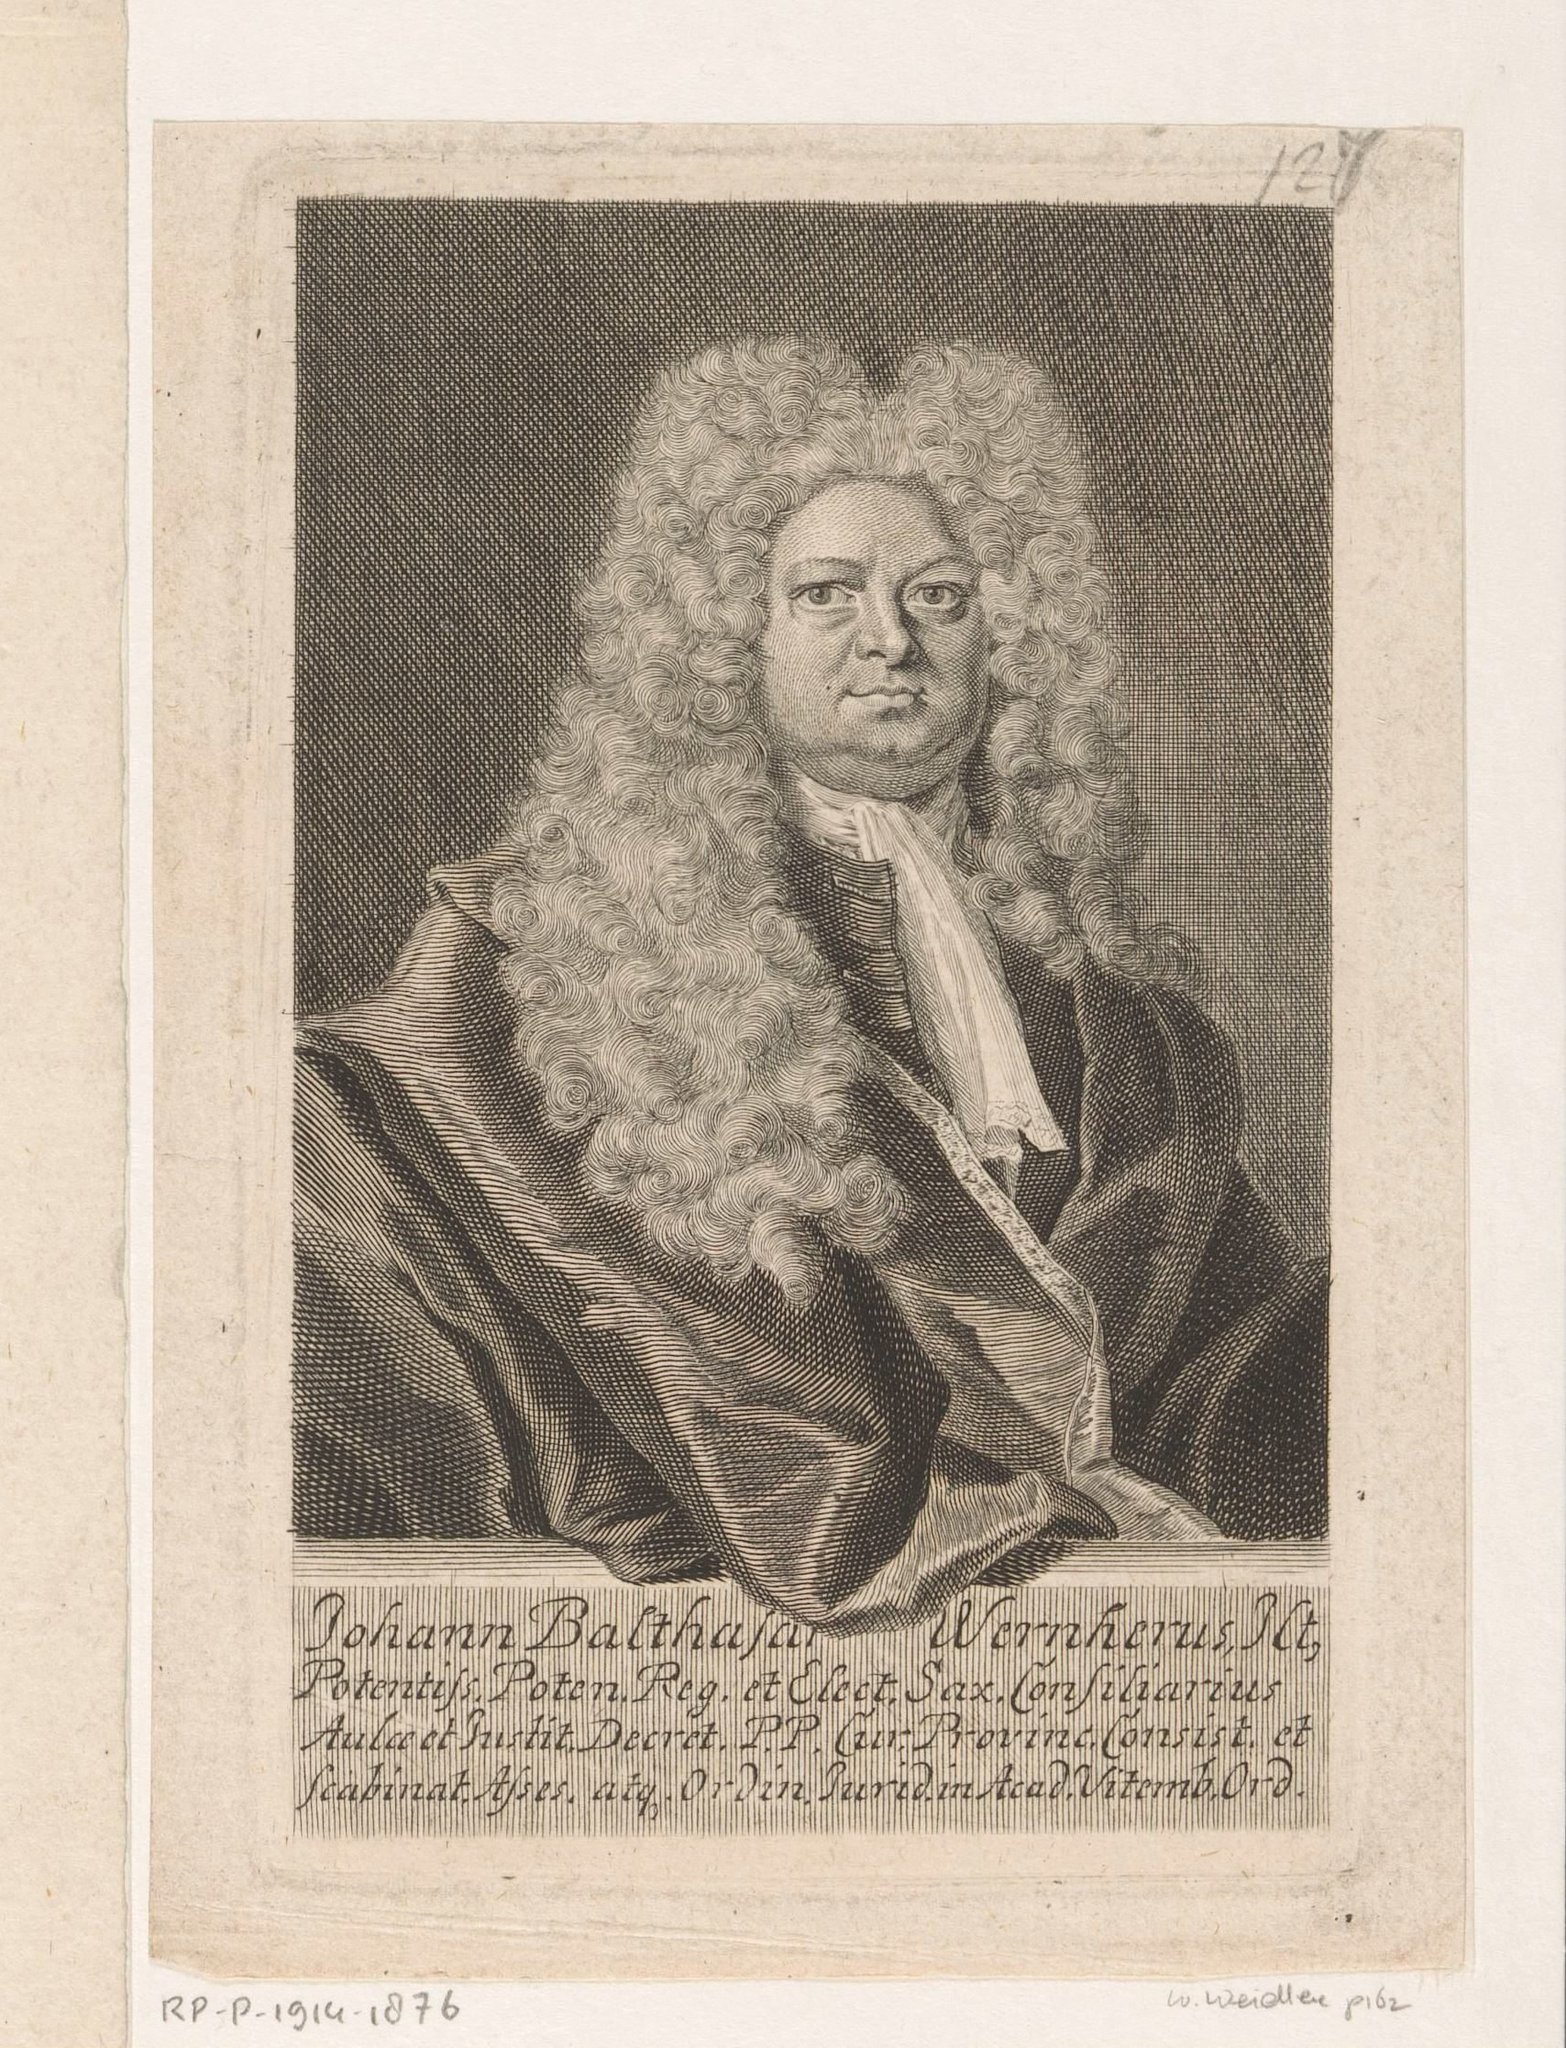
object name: print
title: Portret van Johann Balthasar Wernher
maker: martin bernigeroth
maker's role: print maker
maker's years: 1670-1733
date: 1701-1733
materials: paper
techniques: engraving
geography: leipzig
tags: vienna, johann balthasar wernher, historical persons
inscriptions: collector's mark: Lugt 2228